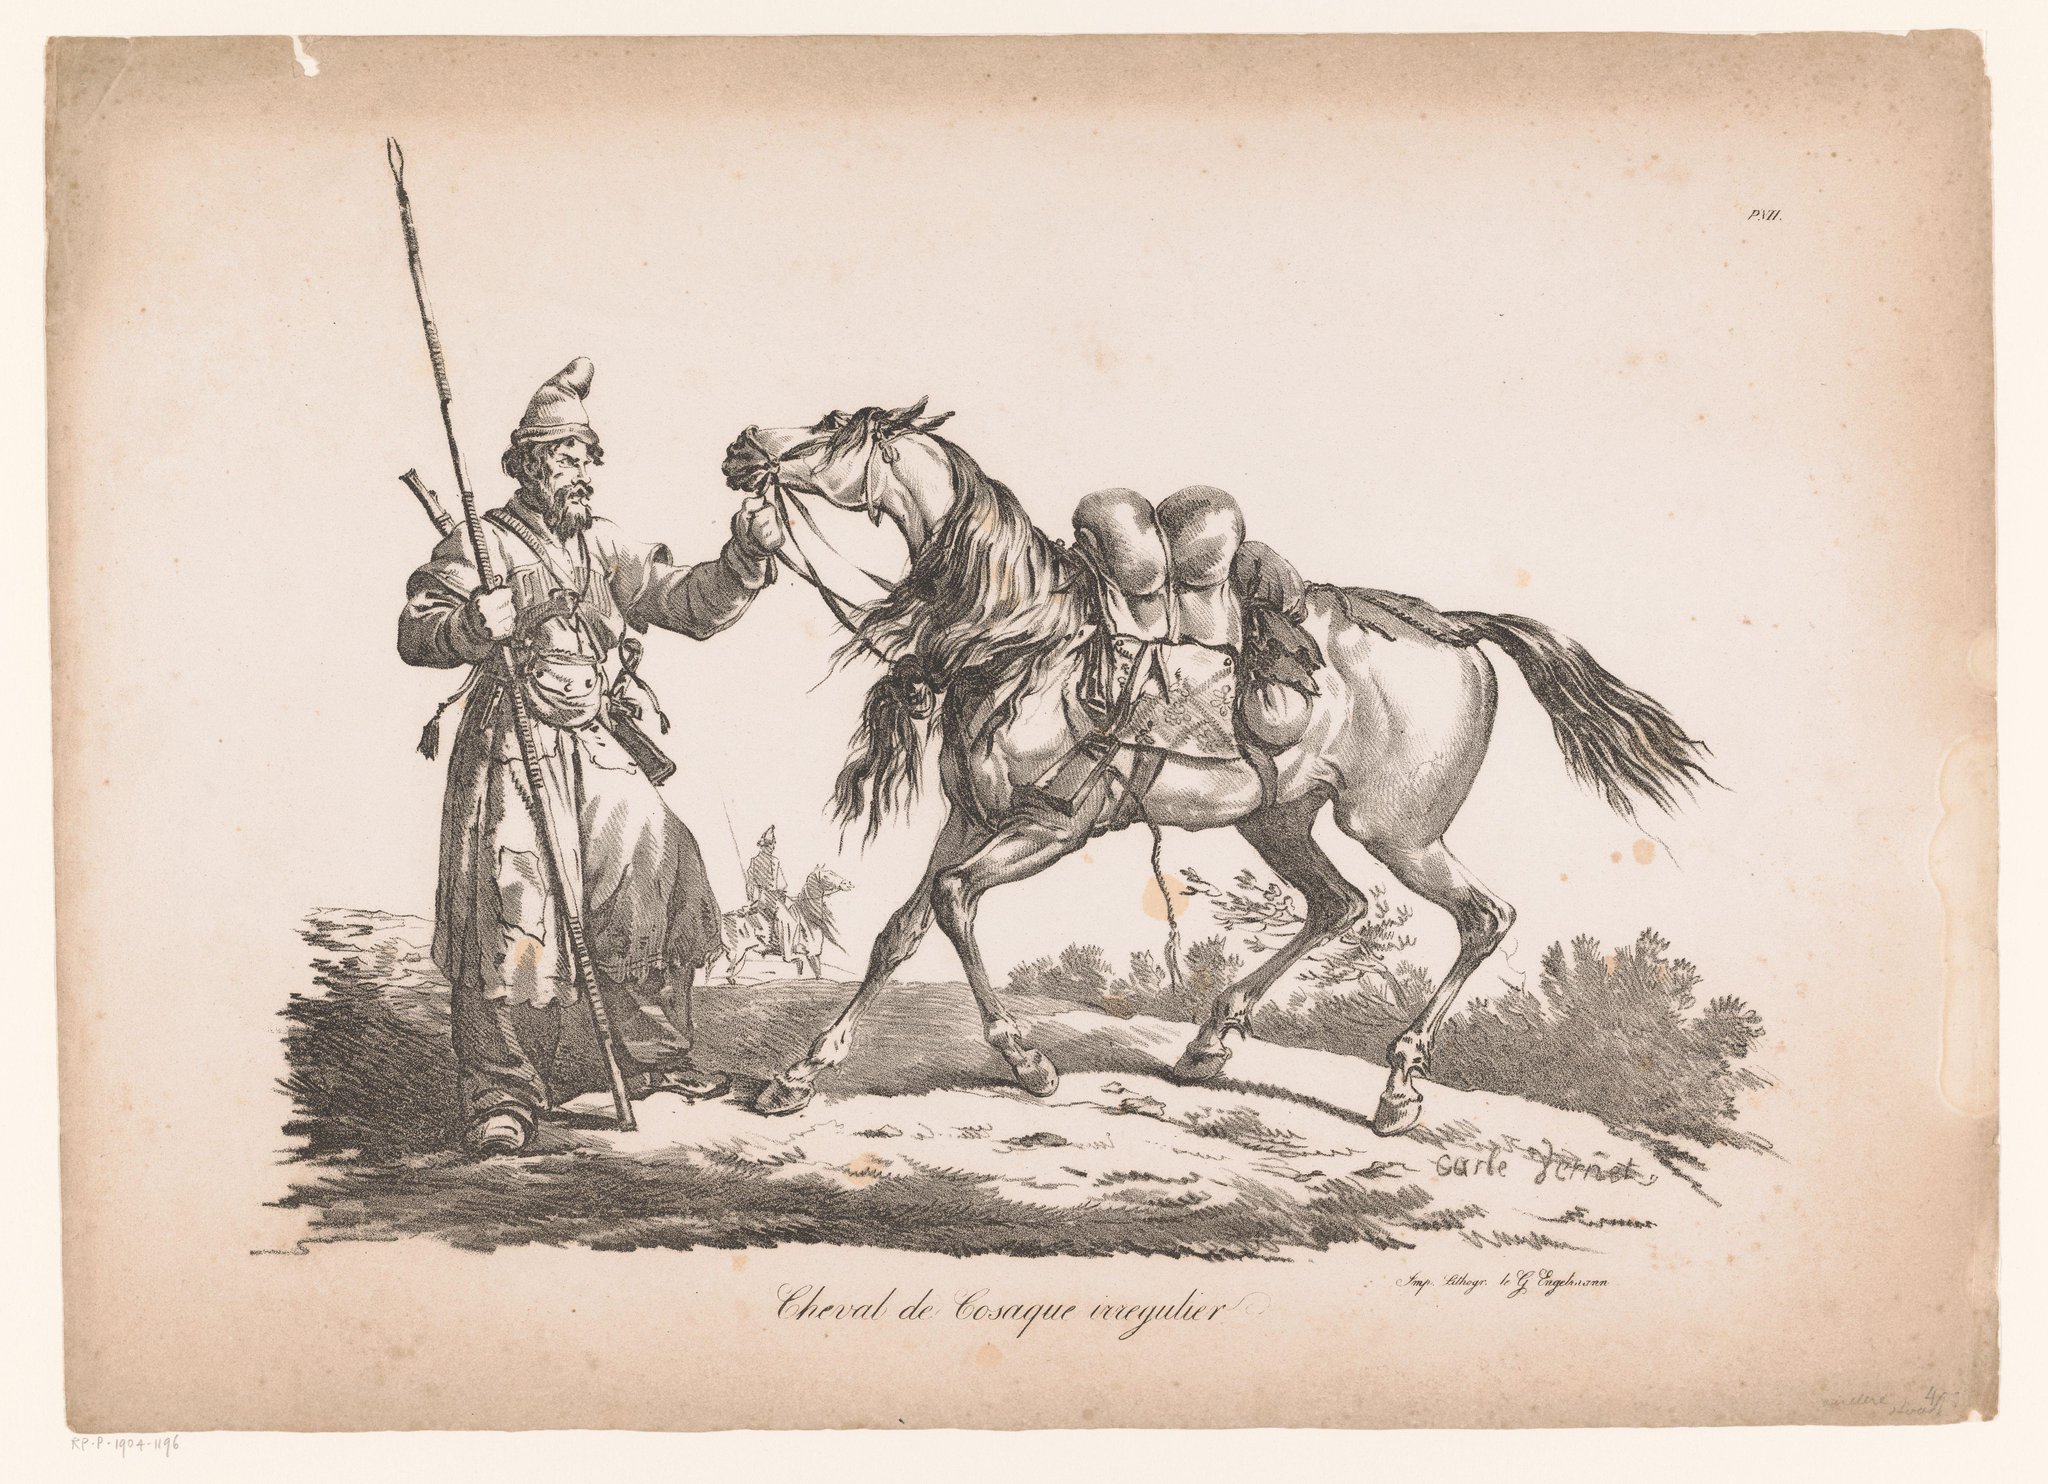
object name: print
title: Cheval de Cosaque irrégulier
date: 1816-1839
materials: paper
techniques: lithograph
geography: paris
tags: the soldier; the soldier's life, horse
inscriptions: collector's mark: Lugt 2228